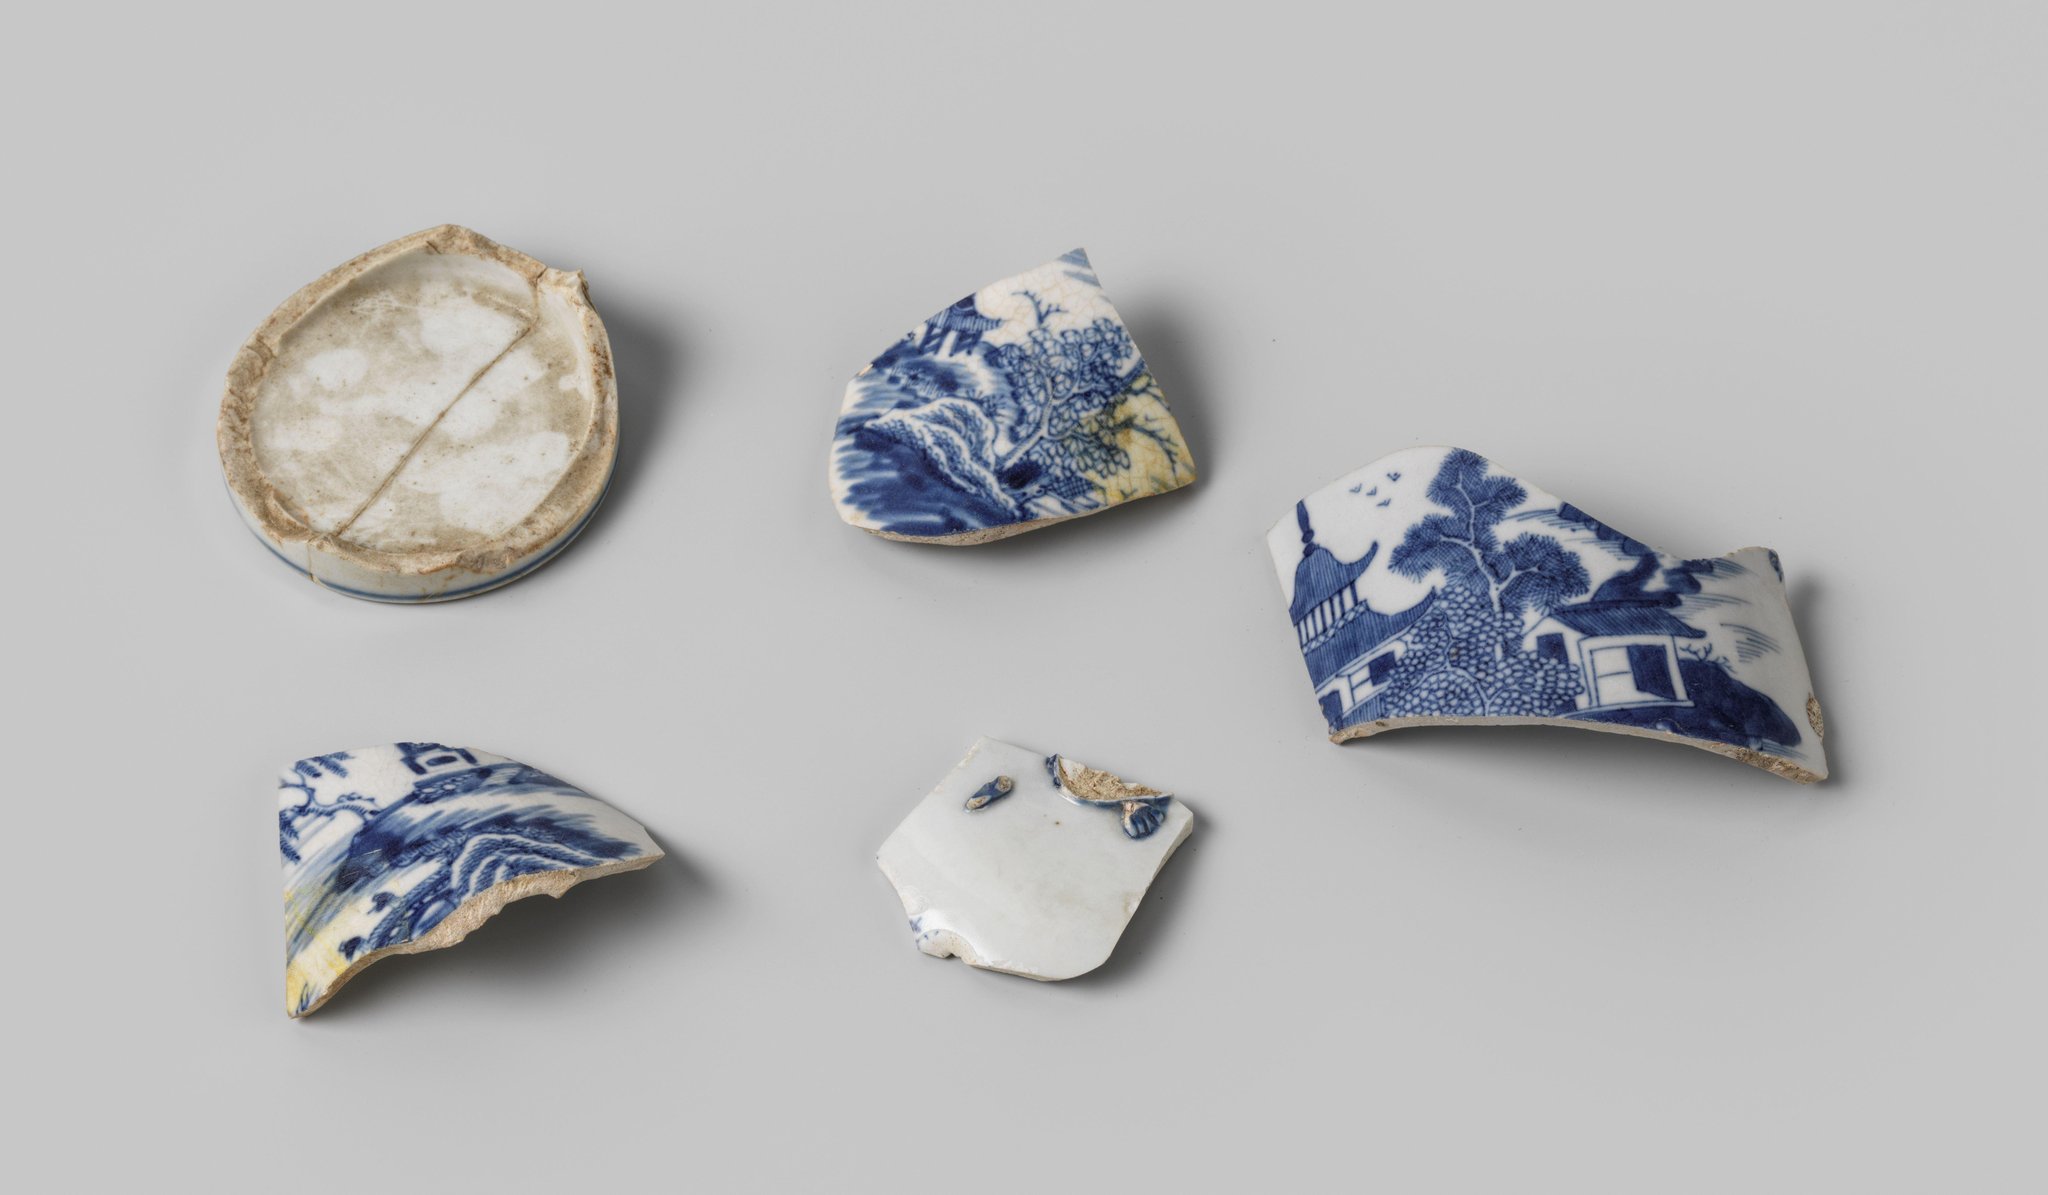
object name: tea cup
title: Vijf porseleinen scherven van een theekop, gevonden bij V.O.C.-schip Witte Leeuw, mogelijk afkomstig van Zeelelie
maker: Anonymous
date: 1750-1799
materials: porcelain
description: Vijf porseleinen scherven van een kop of beker, de bodem bestaat uit twee aan elkaar gelijmde fragmenten, gevonden bij V.O.C.-schip de 'Witte Leeuw'. Dit object is 18e-eeuws en kan dus niet van de vracht van de Witte Leeuw zijn. Onduidelijk is of het object van de site komt of dat het later is vermengd, mogelijk met materiaal van de Zeelelie.